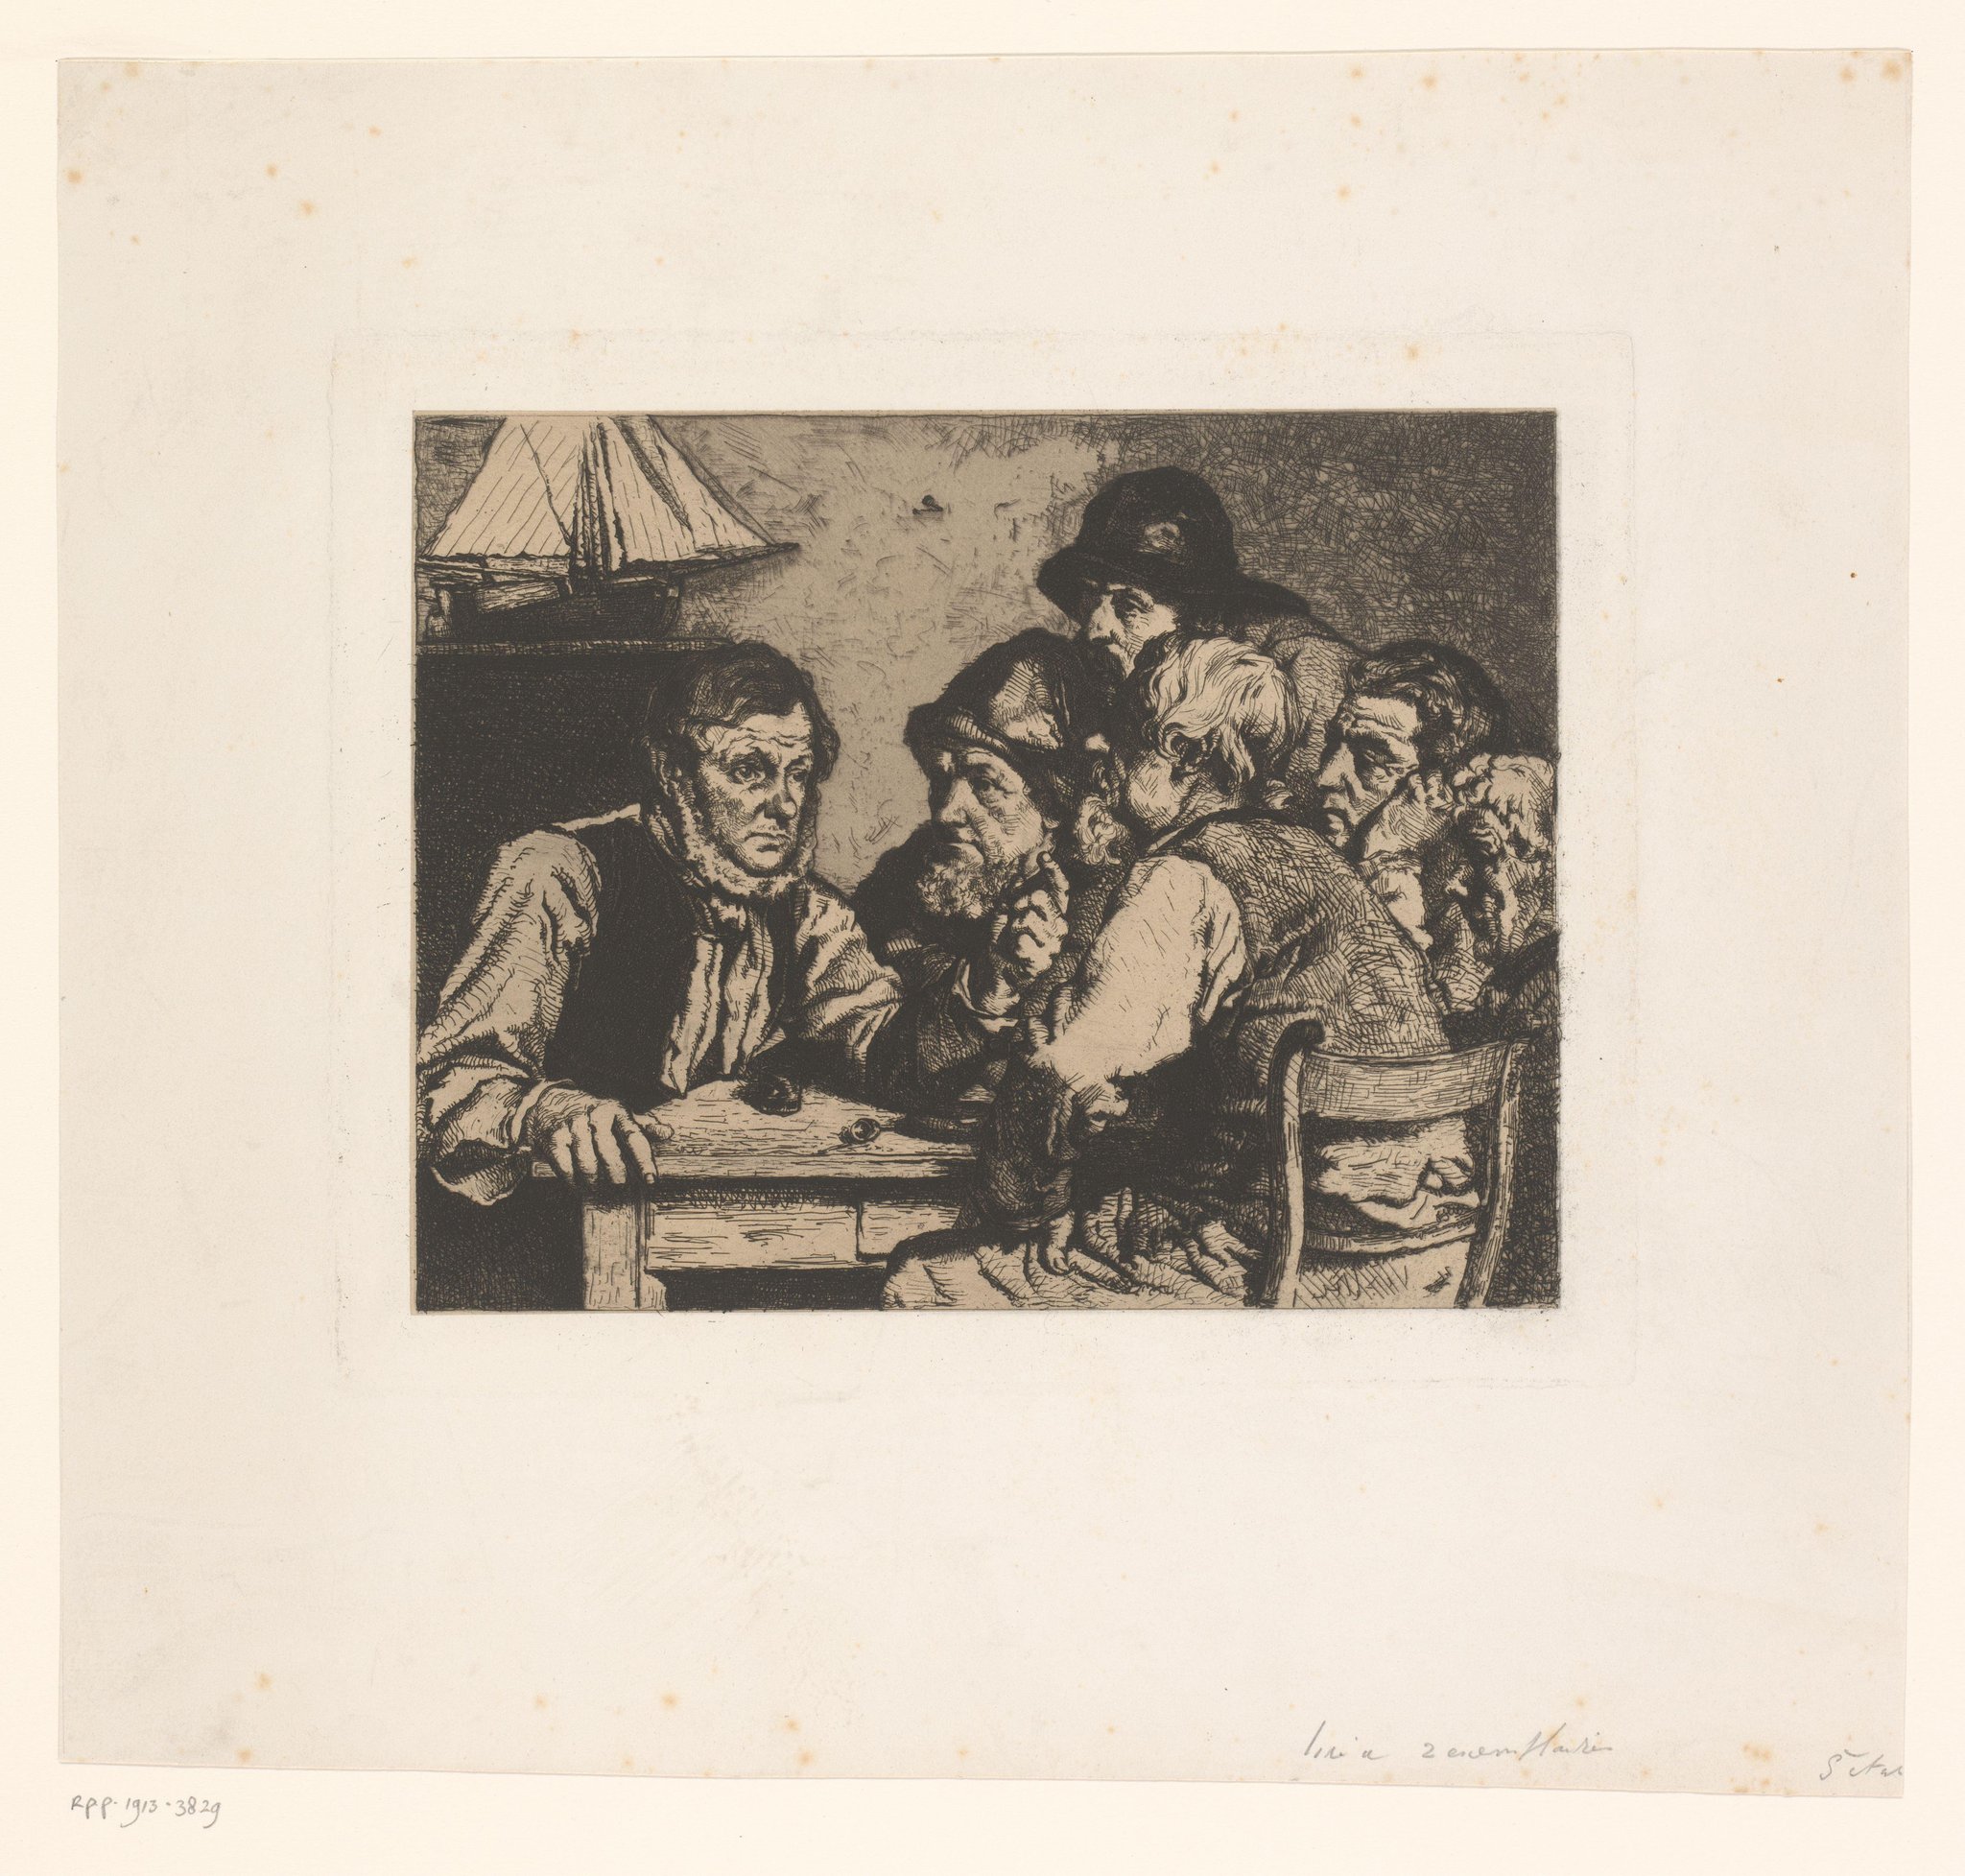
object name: print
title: Zeelieden gezeten aan tafel luisterend naar een van hen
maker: piet verhaert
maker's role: print maker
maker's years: 1852-1908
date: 1879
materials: paper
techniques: etching, intaglio, retroussage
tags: story teller; listening to story teller, table, seaman, ship-model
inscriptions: collector's mark: Lugt 2228, inscription: ‘Tire a 2 exemplare [5] état’